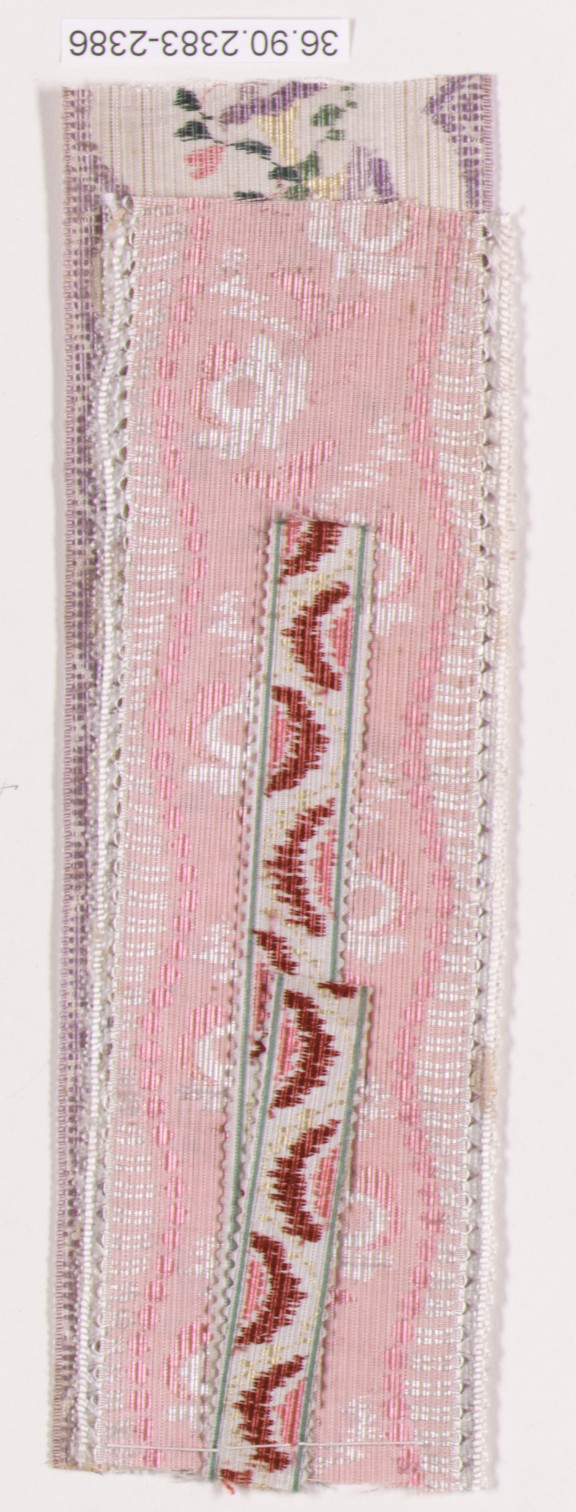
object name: ribbon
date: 1801-1900